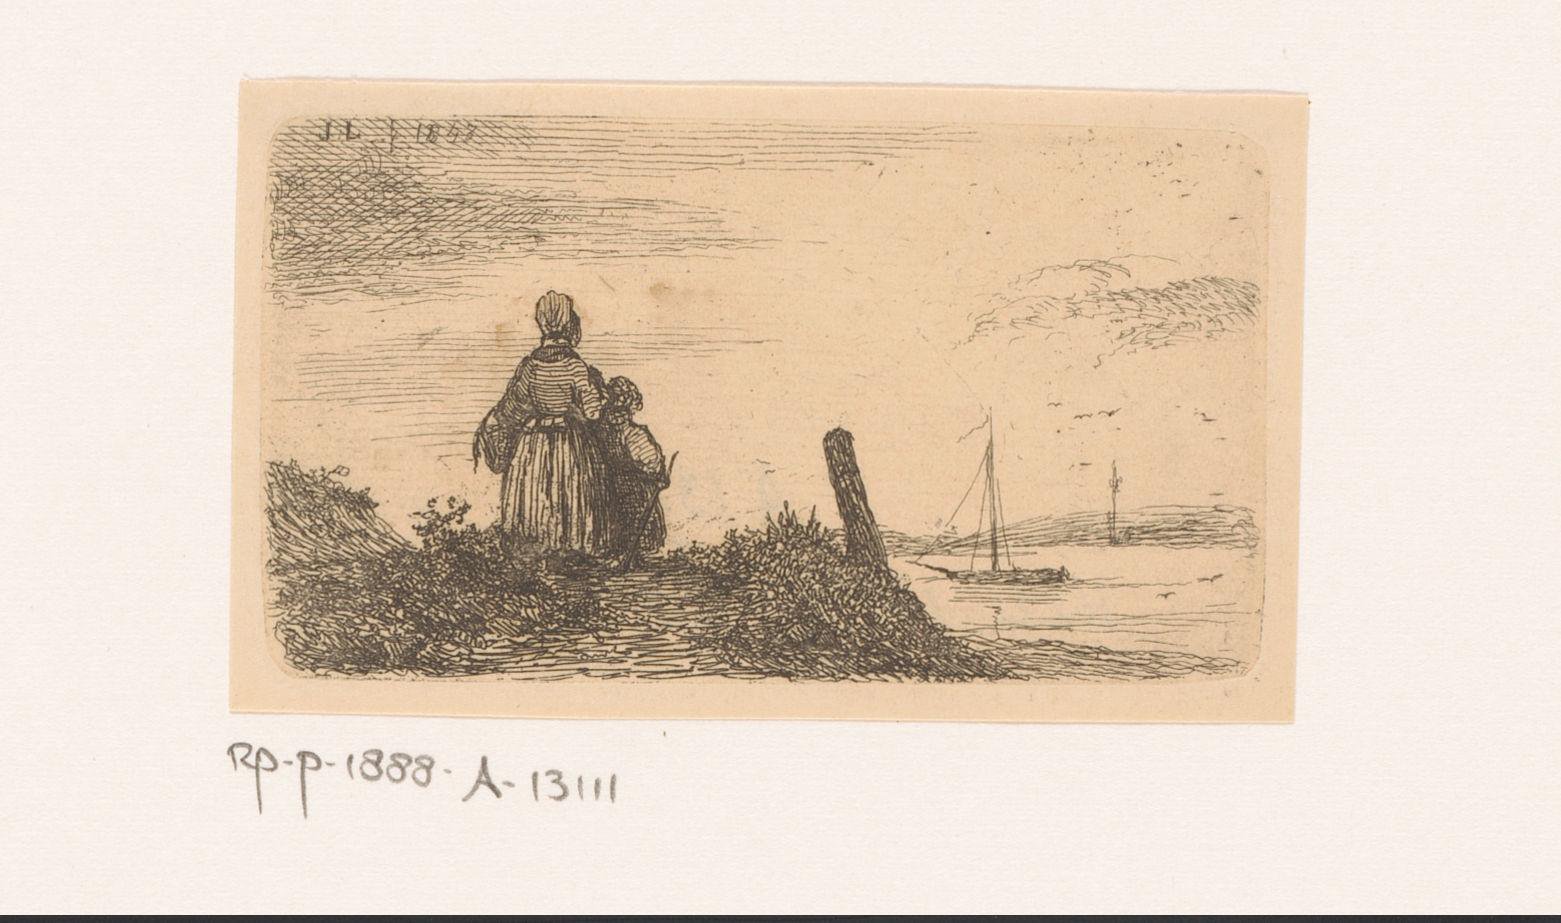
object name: print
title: Vrouw en kind kijken uit over het water naar een voorbij varende zeilboot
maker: jean théodore joseph linnig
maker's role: draughtsman, print maker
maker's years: 1815-1891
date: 1843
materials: paper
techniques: etching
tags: sailing-ship, sailing-boat, mother and child(ren), woman and child(ren) (family group)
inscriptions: collector's mark: Lugt 2228